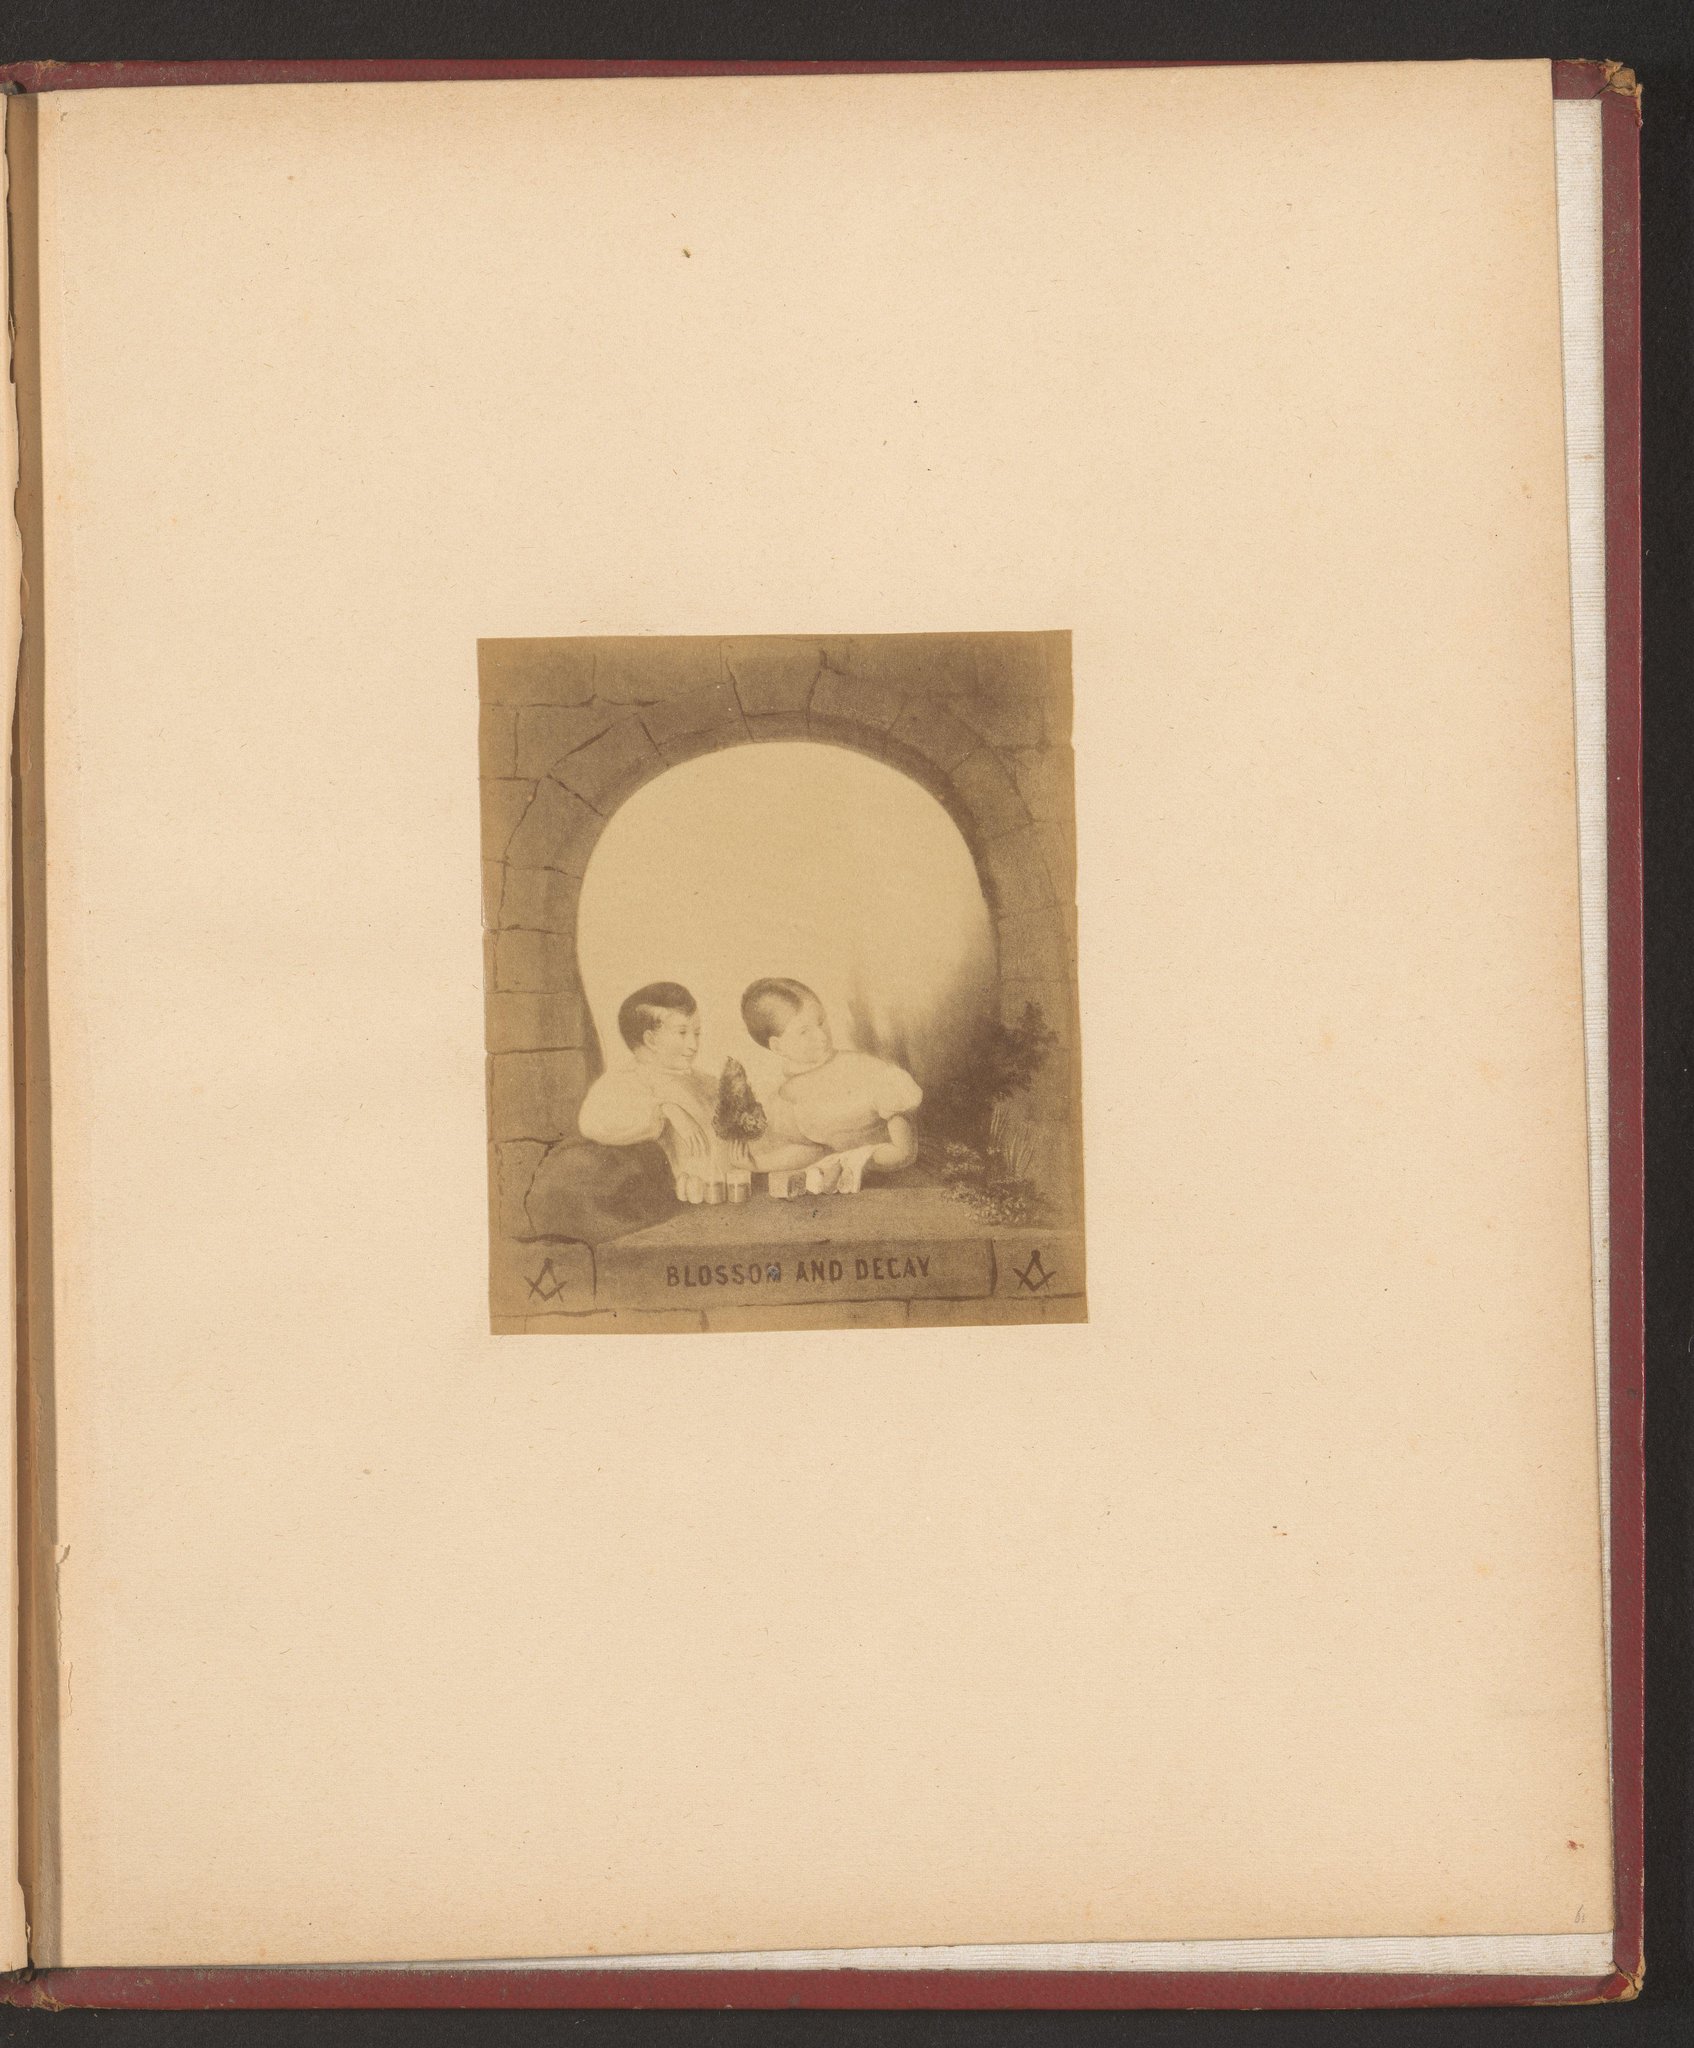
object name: photograph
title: Fotoreproductie van Blossom and Decay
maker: Anonymous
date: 1875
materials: paper, photographic support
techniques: albumen print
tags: boy (child between toddler and youth), girl (child between toddler and youth), death's head, skull (symbol of death)